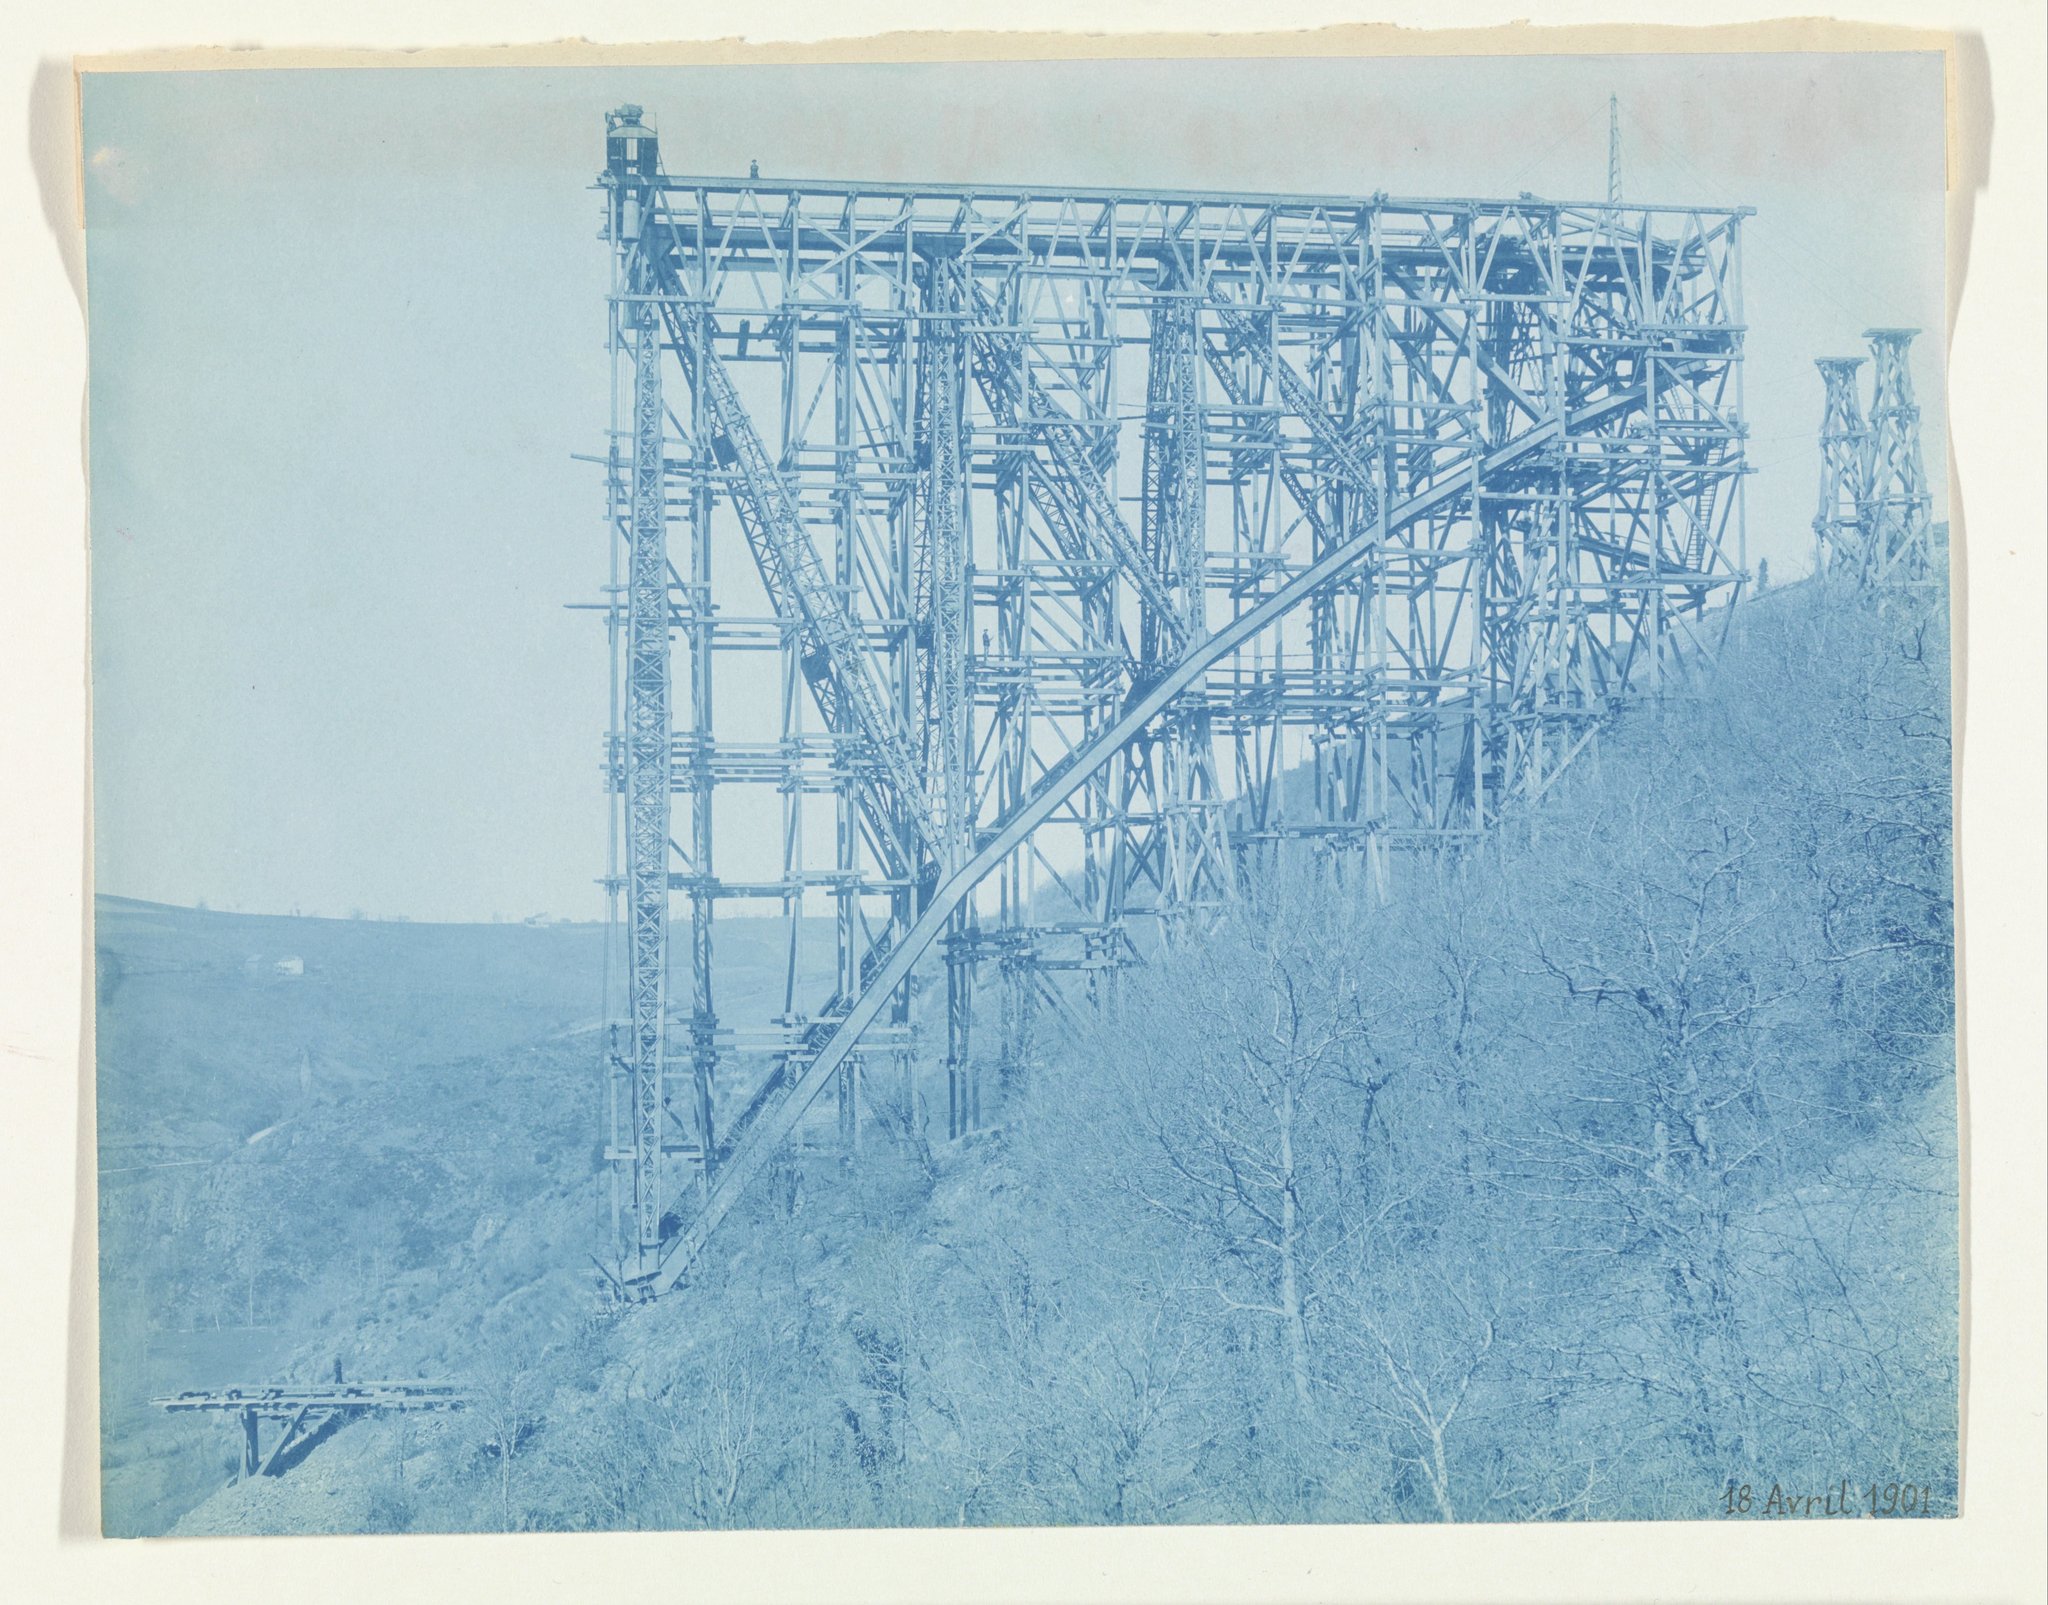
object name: photograph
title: Aanleg van het Viaur Viaduct in Frankrijk door de Societé de Construction des Battignolles, 18 april 1901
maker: Anonymous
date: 1901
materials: photographic support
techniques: cyanotype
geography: france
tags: viaduct, making the overground structures (~ building activities)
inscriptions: date